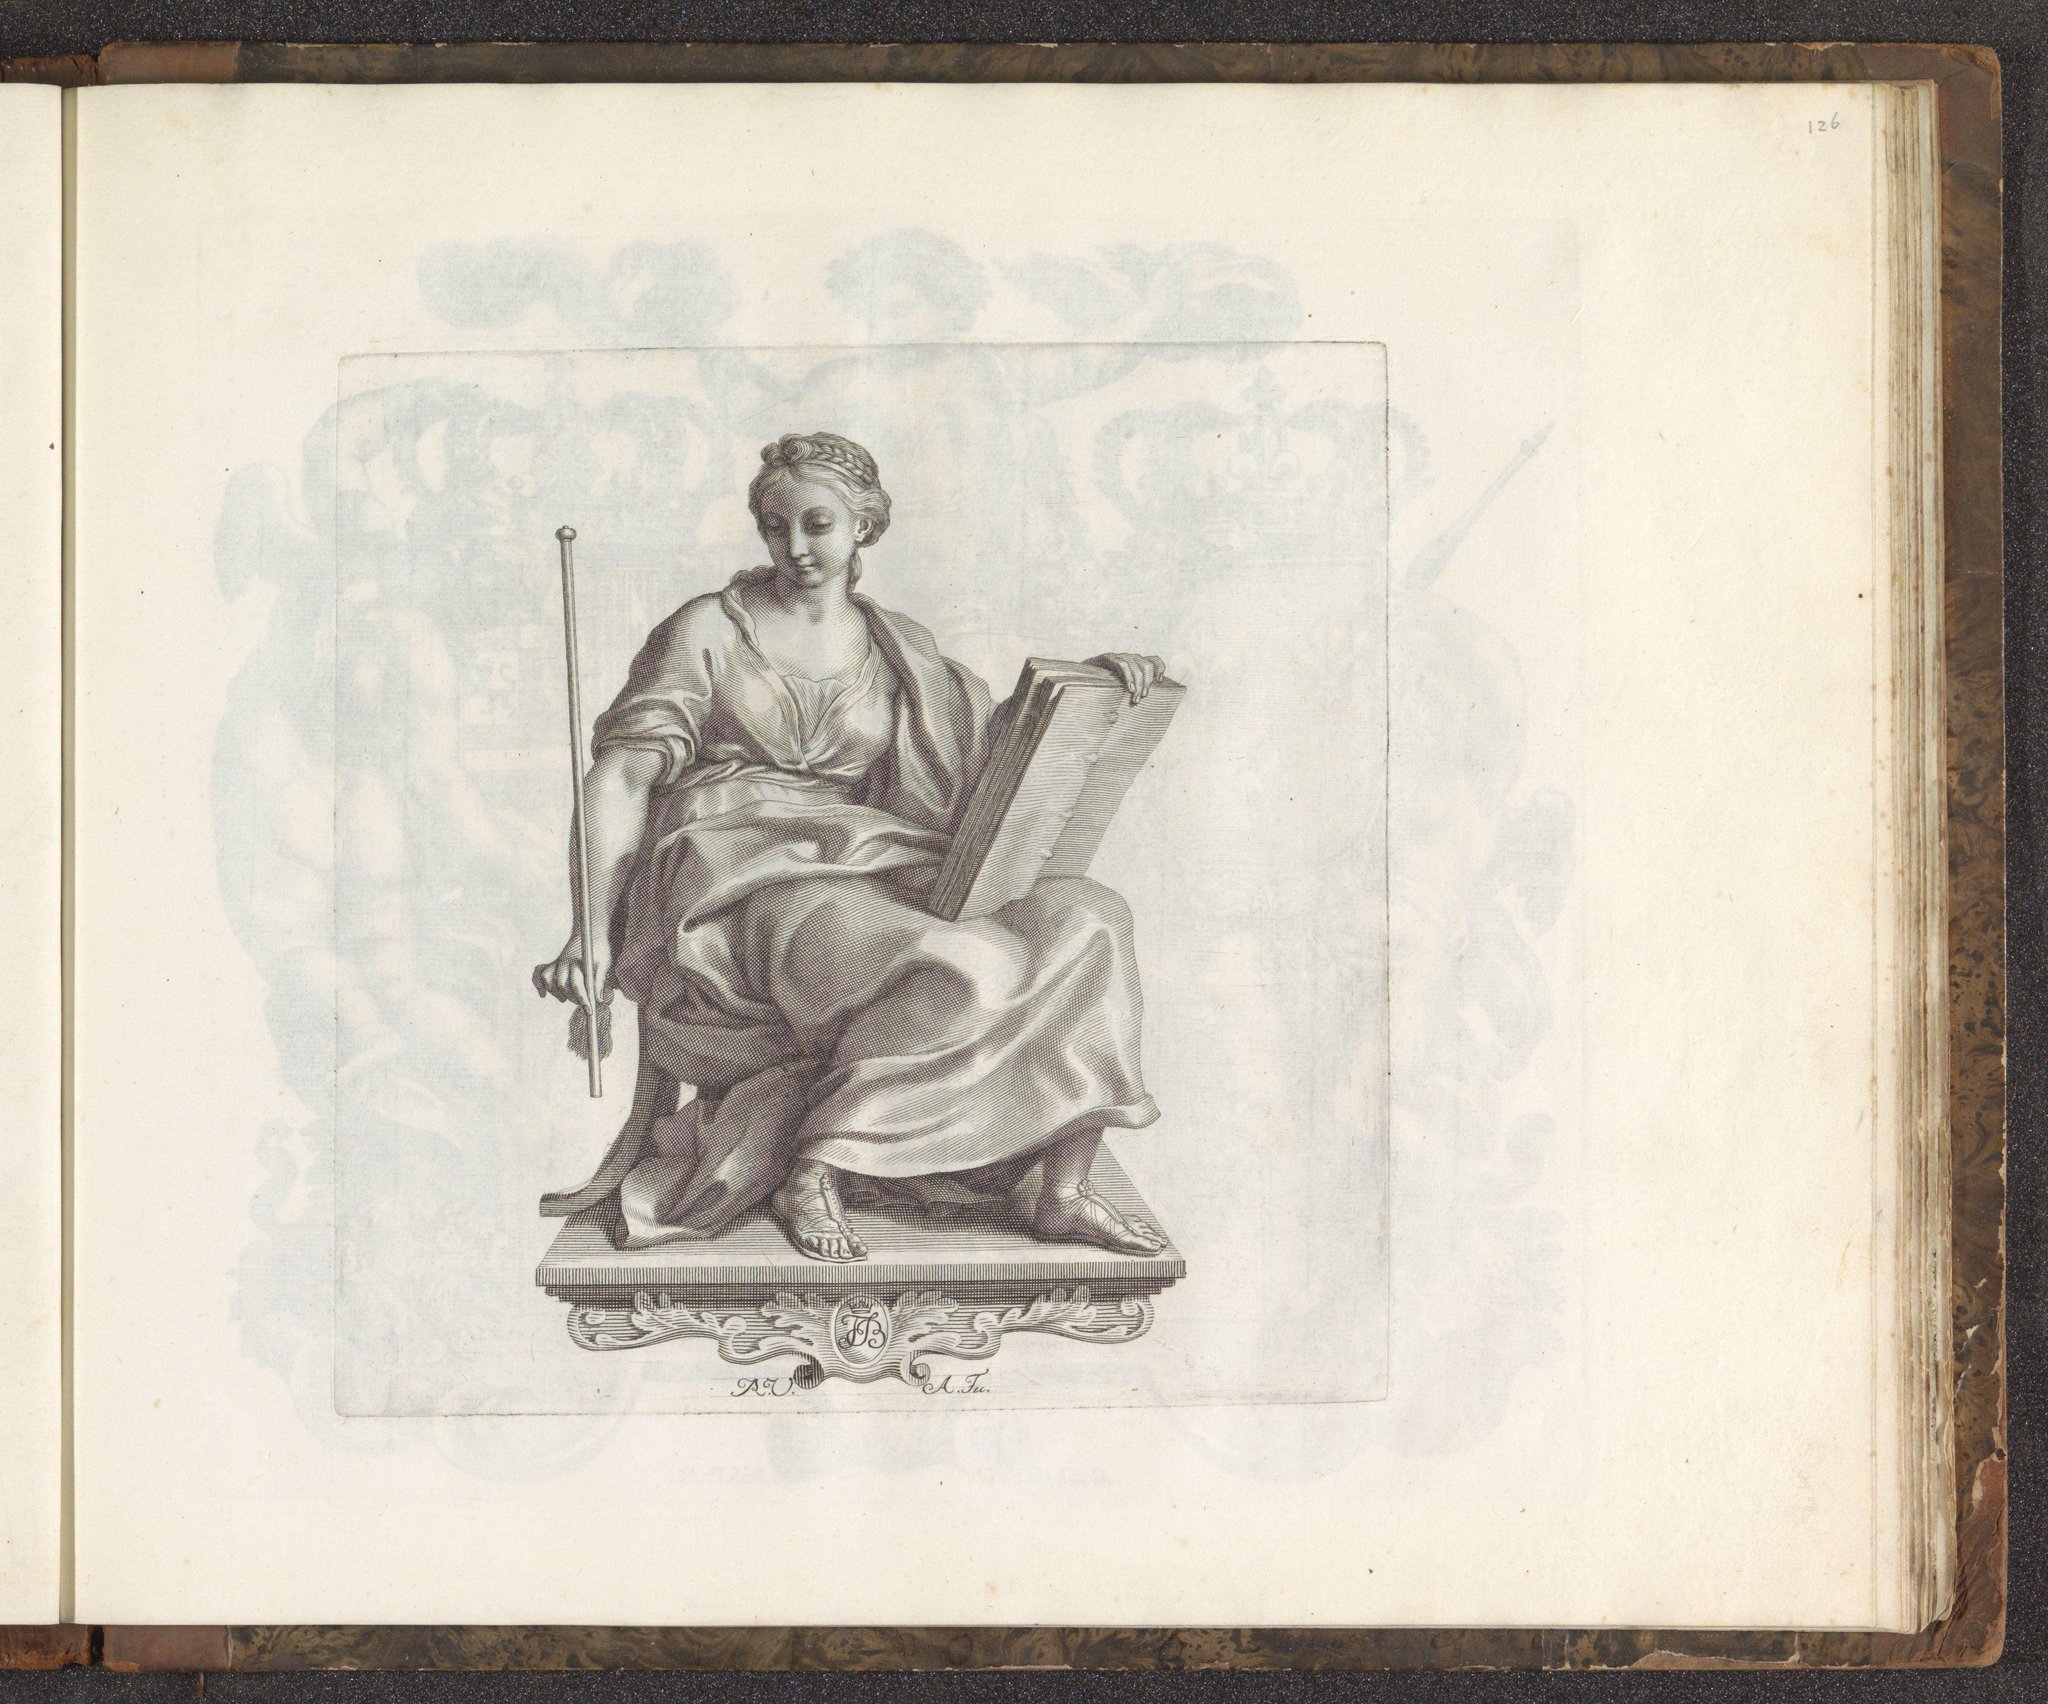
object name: print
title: Personificatie van Kennis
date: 1673-1743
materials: paper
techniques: engraving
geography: rome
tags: knowledge; 'cognitione', 'cognitione delle cose' (ripa)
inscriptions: collector's mark: Lugt 2228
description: Een console met de vrouwelijke personificatie van Kennis met in haar rechterhand een roede en in haar linkerhand een boek. De prent maakt deel uit van een album.